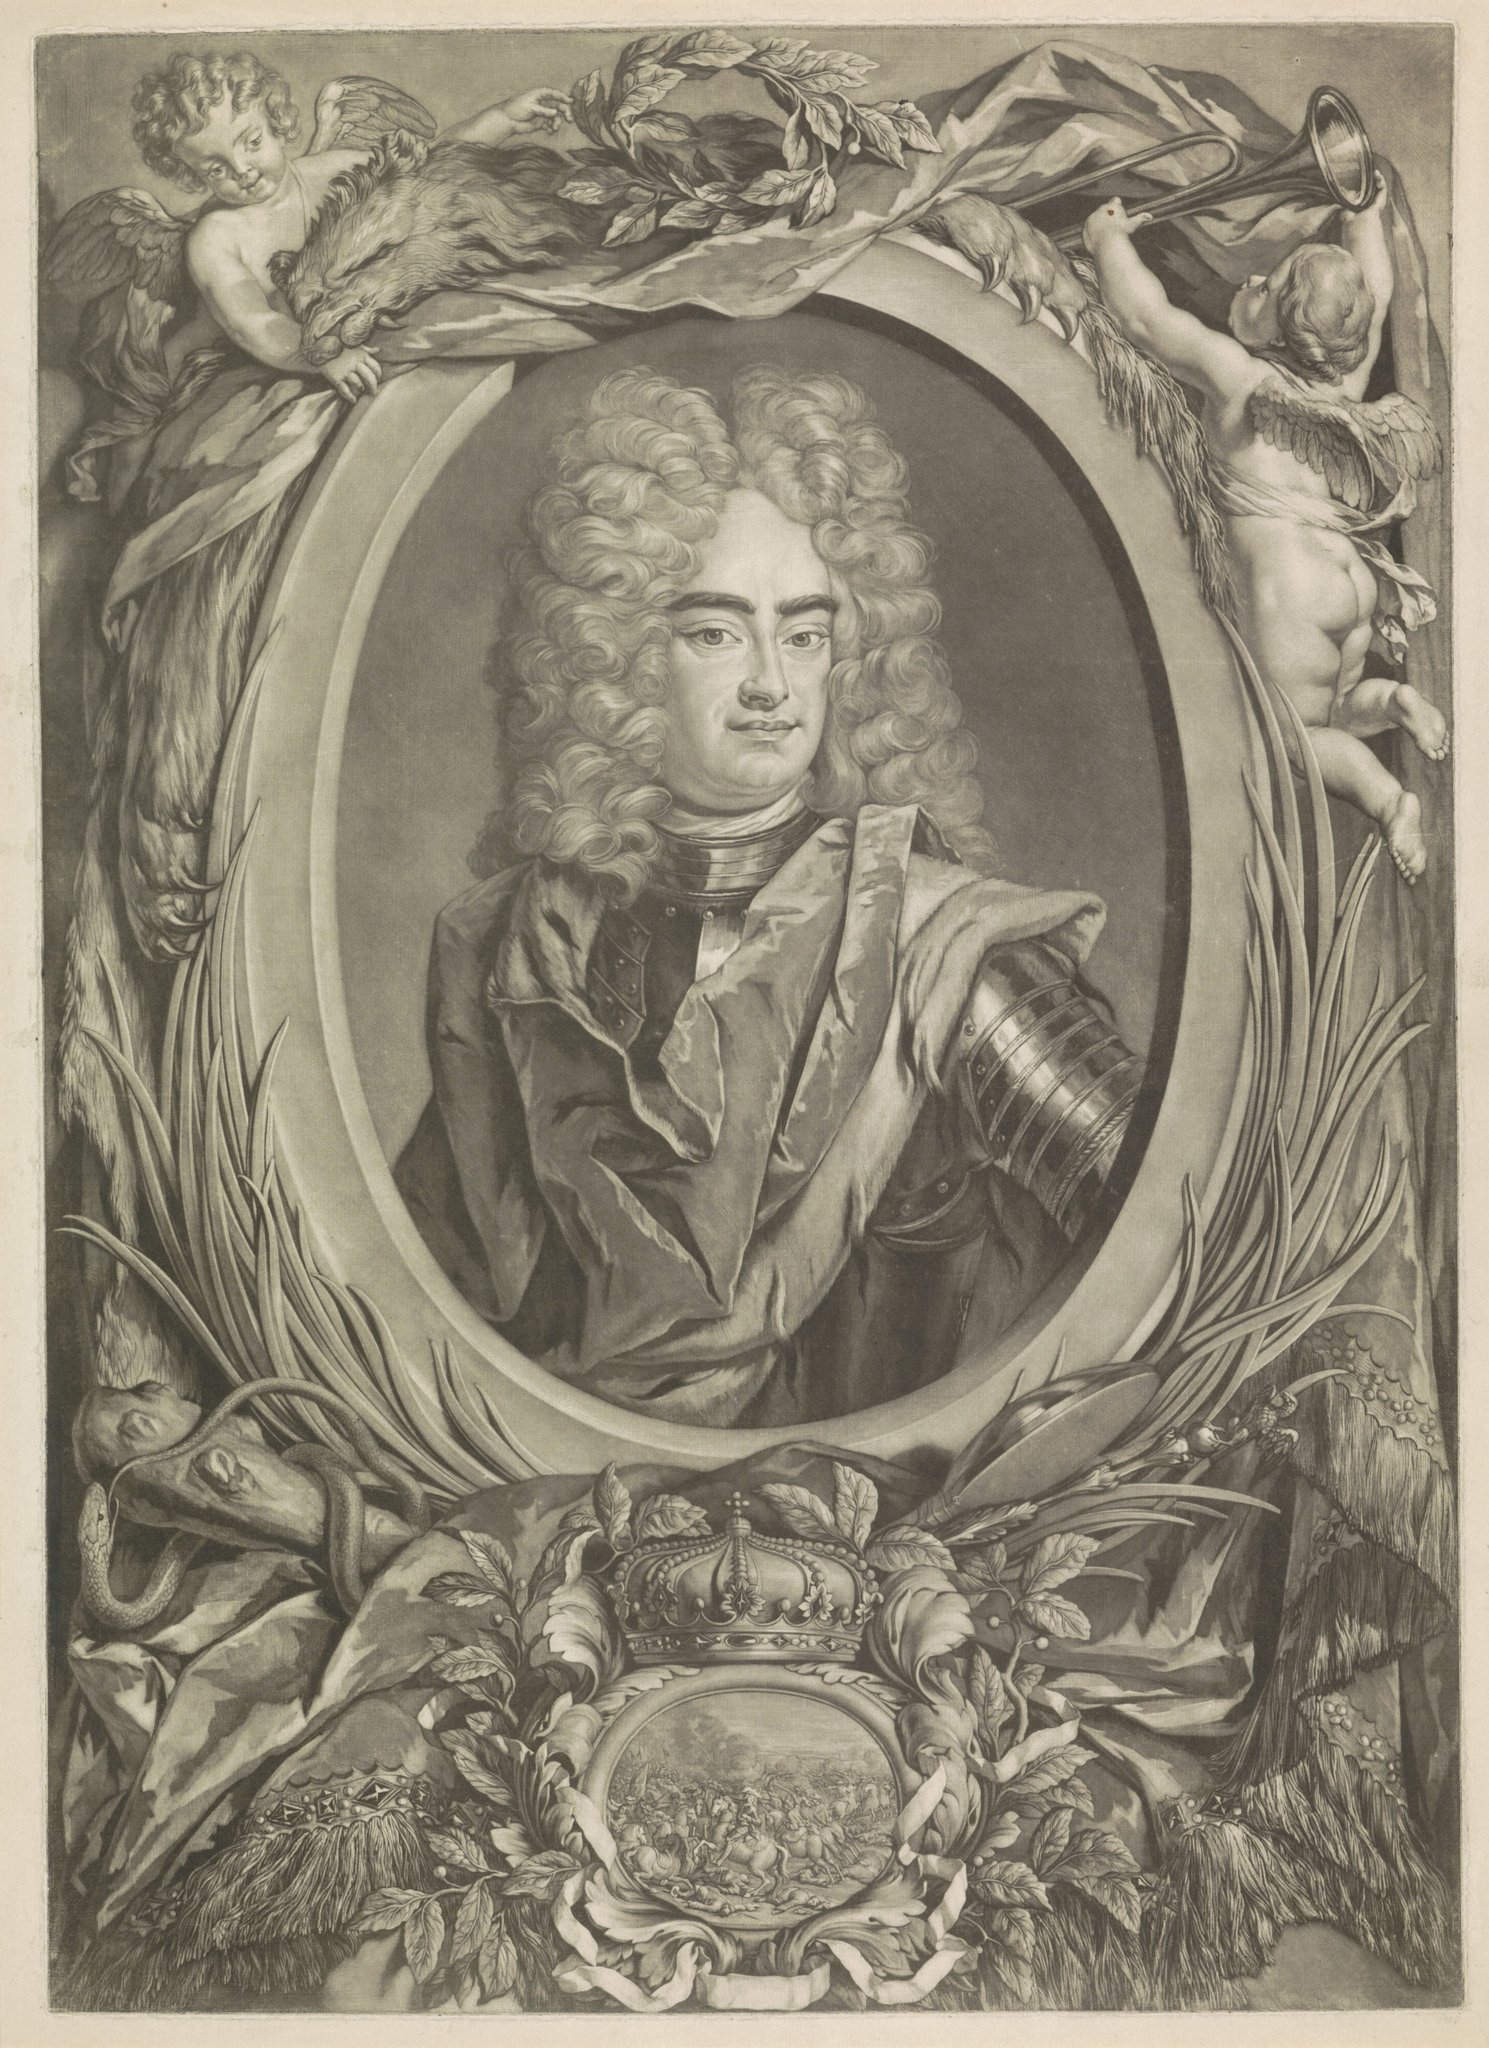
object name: print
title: Portret van Frederik Augustus II, hertog van Saksen en koning van Polen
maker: nicolaas verkolje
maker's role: draughtsman, painter, print maker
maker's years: 1673-1746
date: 1706-1746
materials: paper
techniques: mezzotint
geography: amsterdam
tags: augustus iii (king of poland)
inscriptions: collector's mark: Lugt 2228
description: Frederik Augustus II, hertog van Saksen en koning van Polen met een harnas en een lange krulpruik. De omlijsting is versierd met palmbladeren, een knots en een slang, een vlag, een scepter en twee putti; een met een leeuwenvel en de ander met een loftrompet. Boven het hoofd van de koning zweeft een lauwerkrans. Onder de omlijsting een gekroonde lijst met een afbeelding van de slag bij Kalisch (29-10-1706).